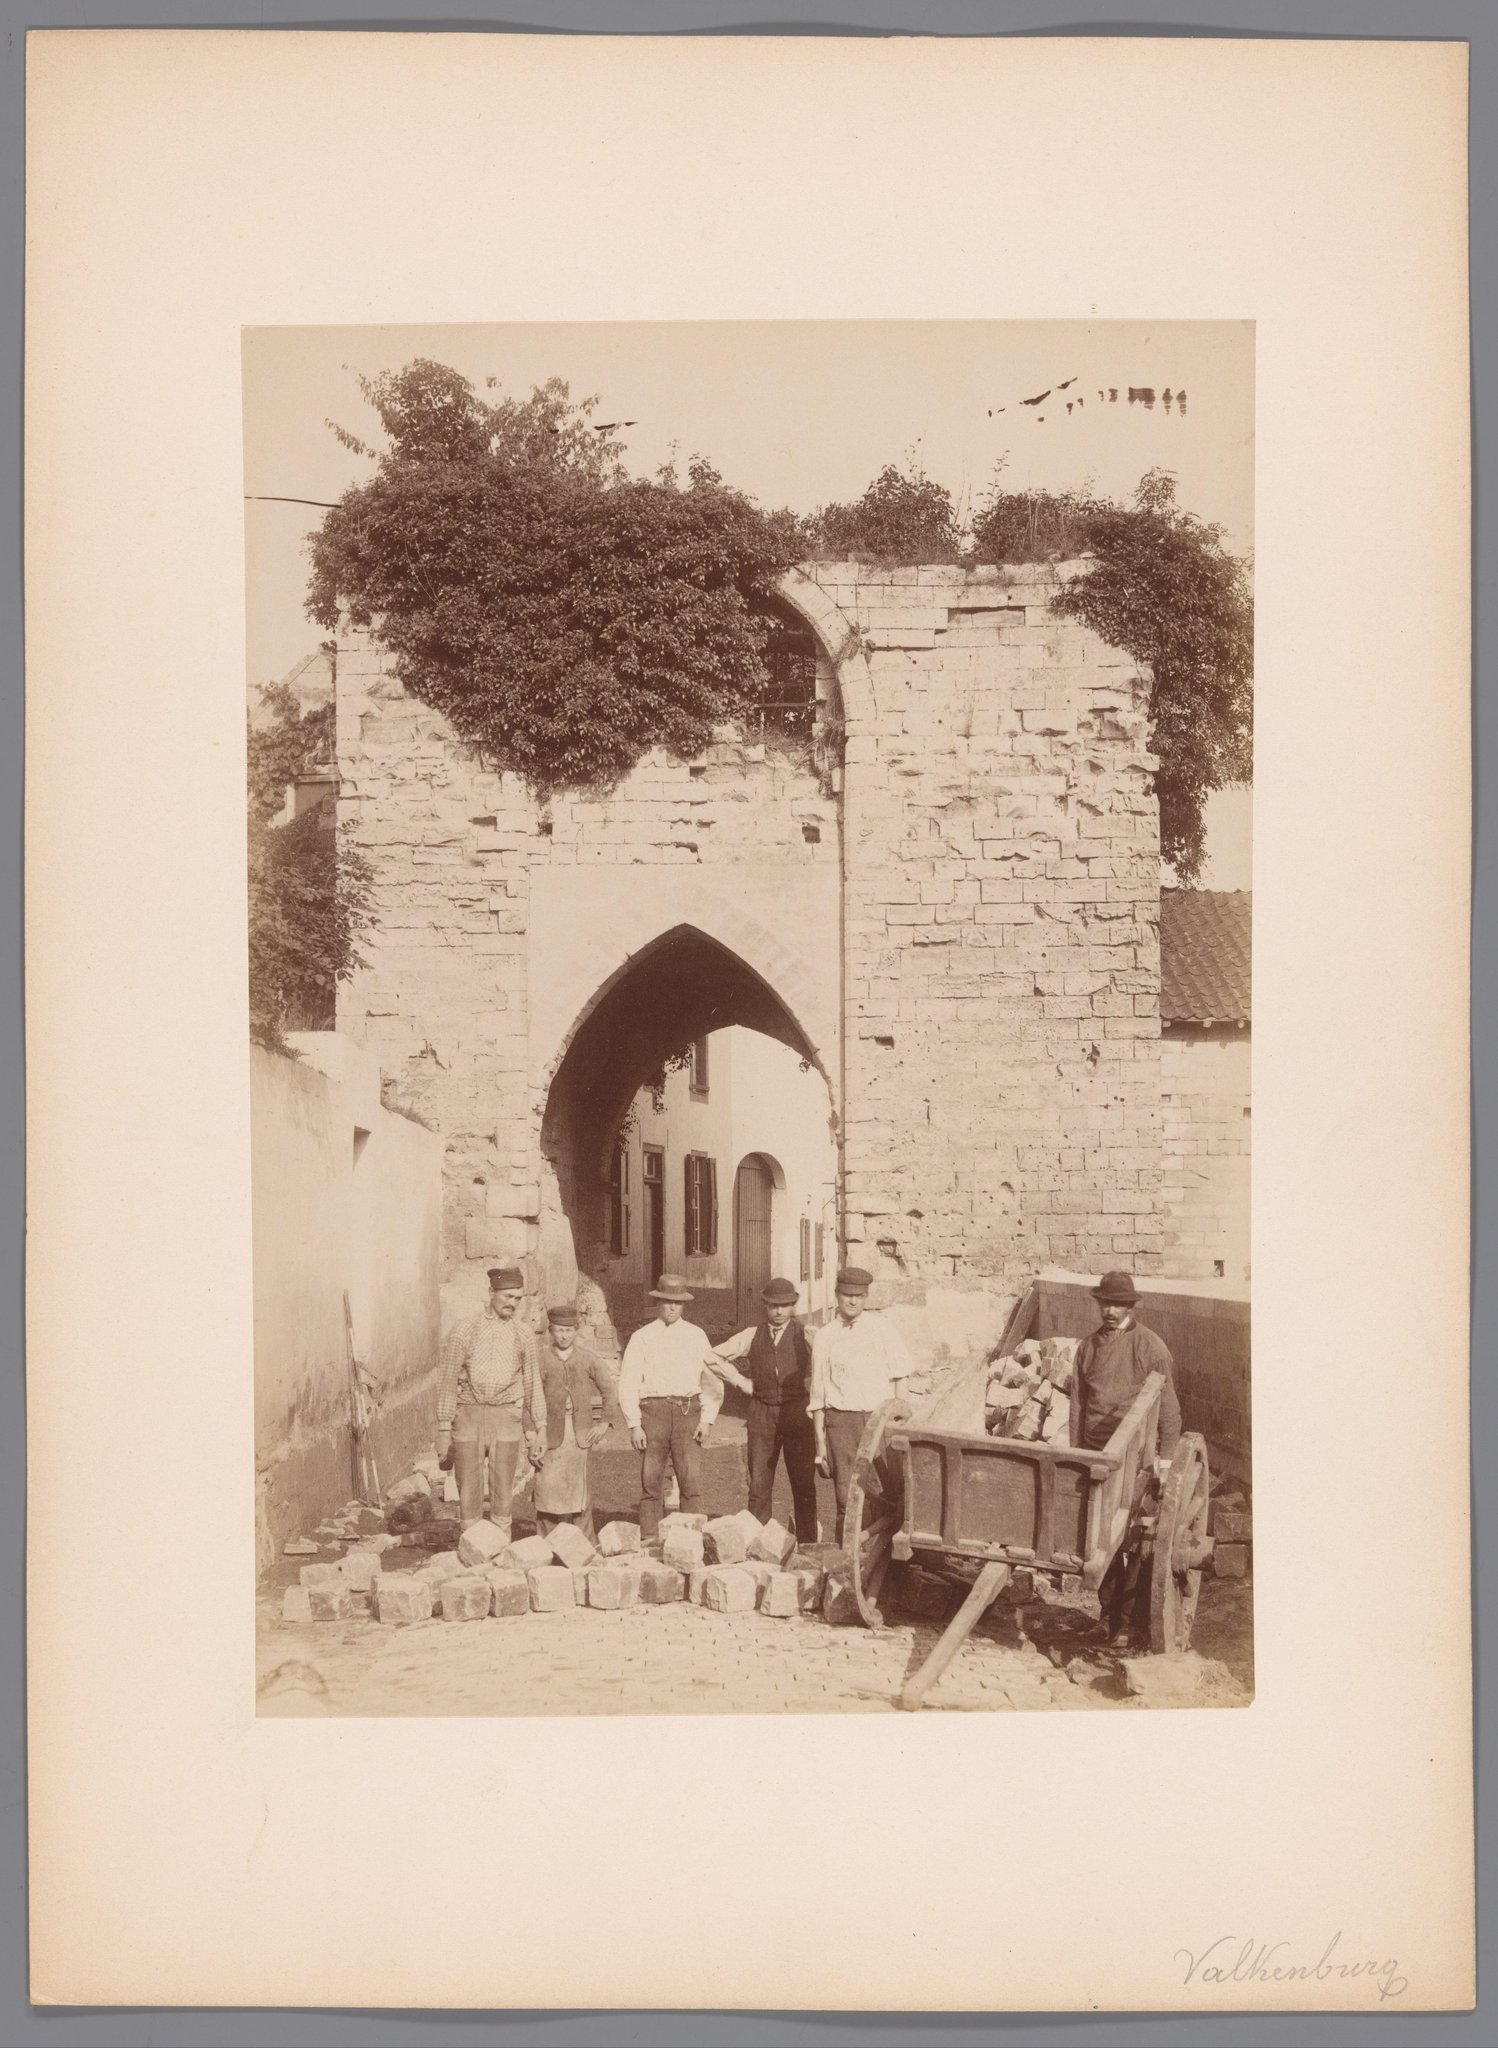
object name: photograph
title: Buitenzijde van de Berkelpoort te Valkenburg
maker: anoniem (monumentenzorg)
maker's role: fotograaf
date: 1890-1920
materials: cardboard, photographic support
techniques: albumen print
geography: valkenburg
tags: hand-cart, city-gate (+ city(-scape) with figures, staffage)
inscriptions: annotation: ‘Valkenburg’, annotation: ‘Berkelpoot te Valkenburg/ Buitenzijde’